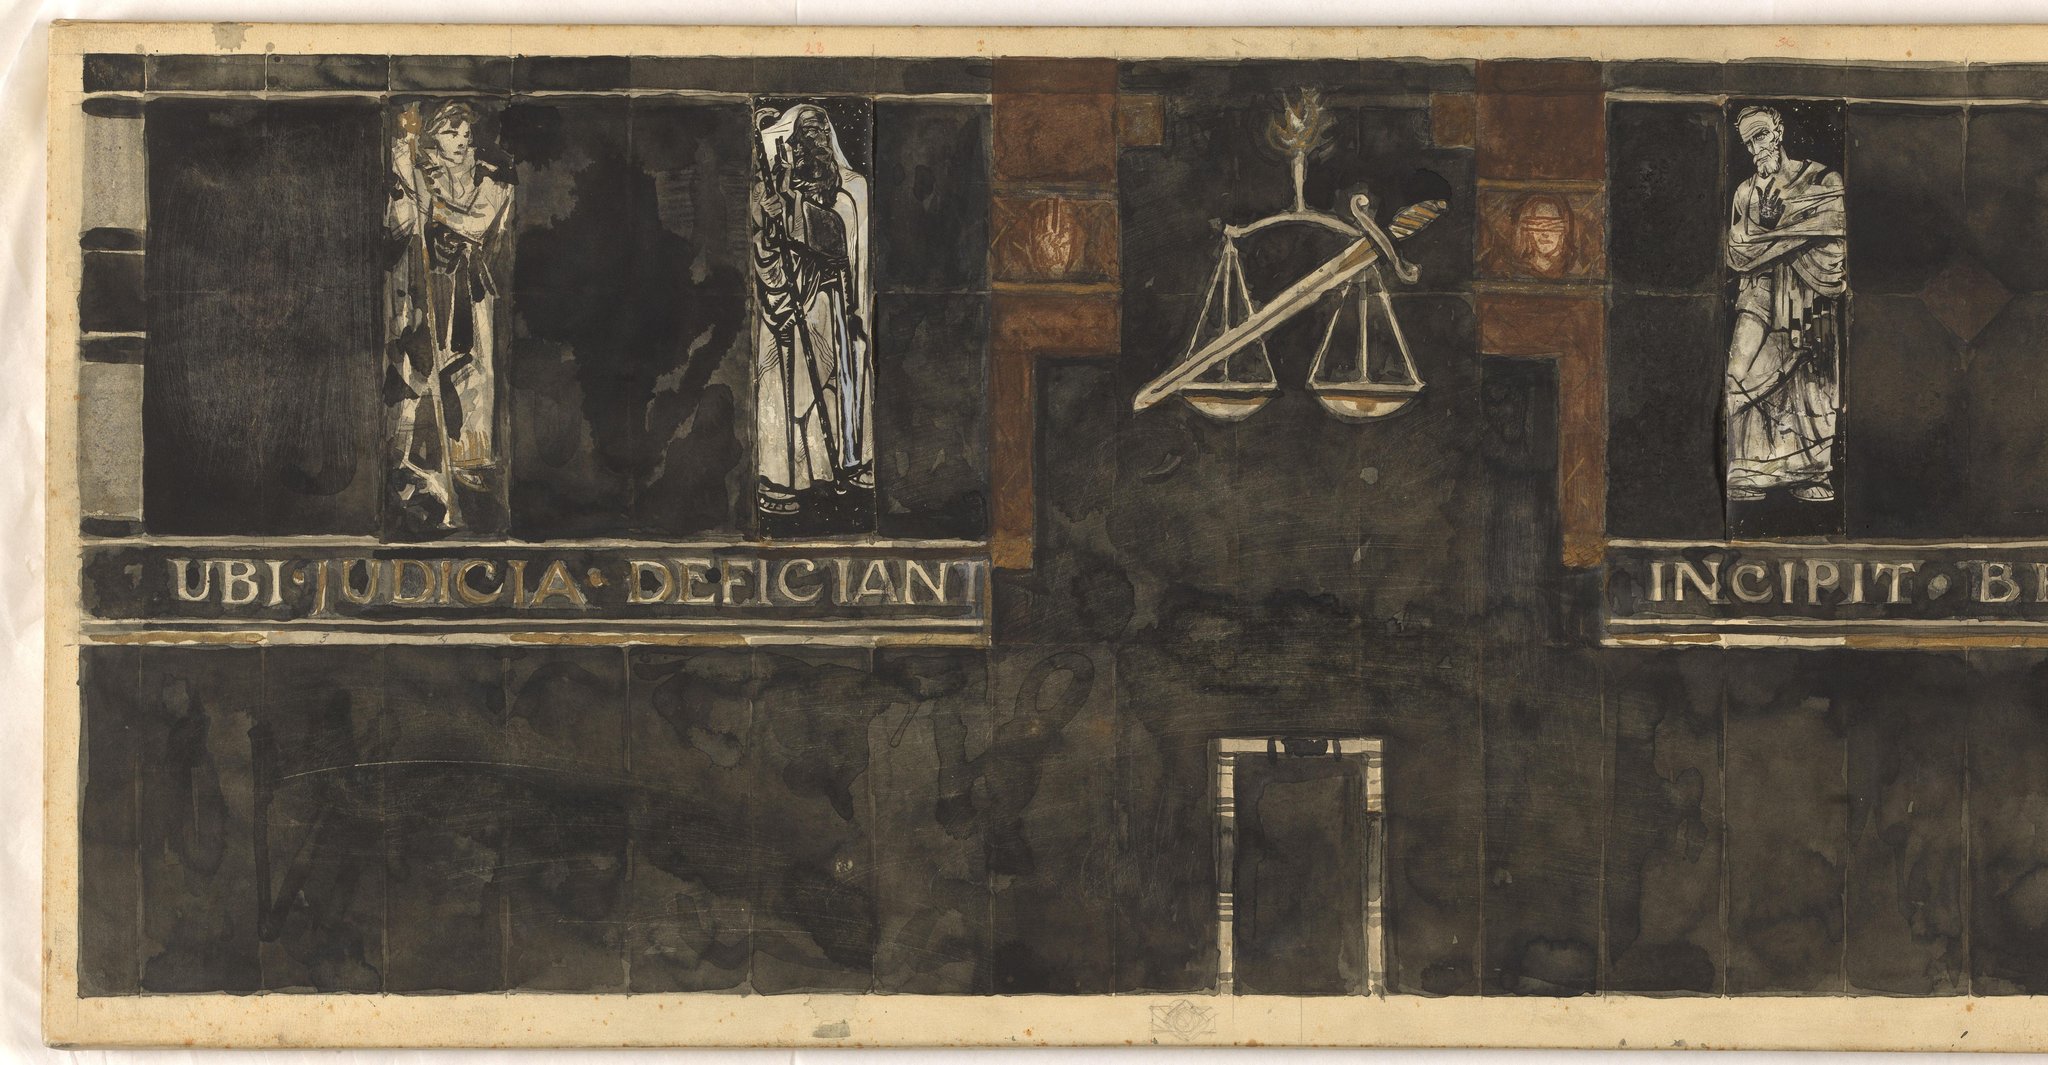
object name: drawing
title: Derde ontwerp voor marmerdecoratie in de Hoge Raad te Den Haag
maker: richard nicolaüs roland holst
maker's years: 1868-1938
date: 1868-1938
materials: chalk, pencil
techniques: brush